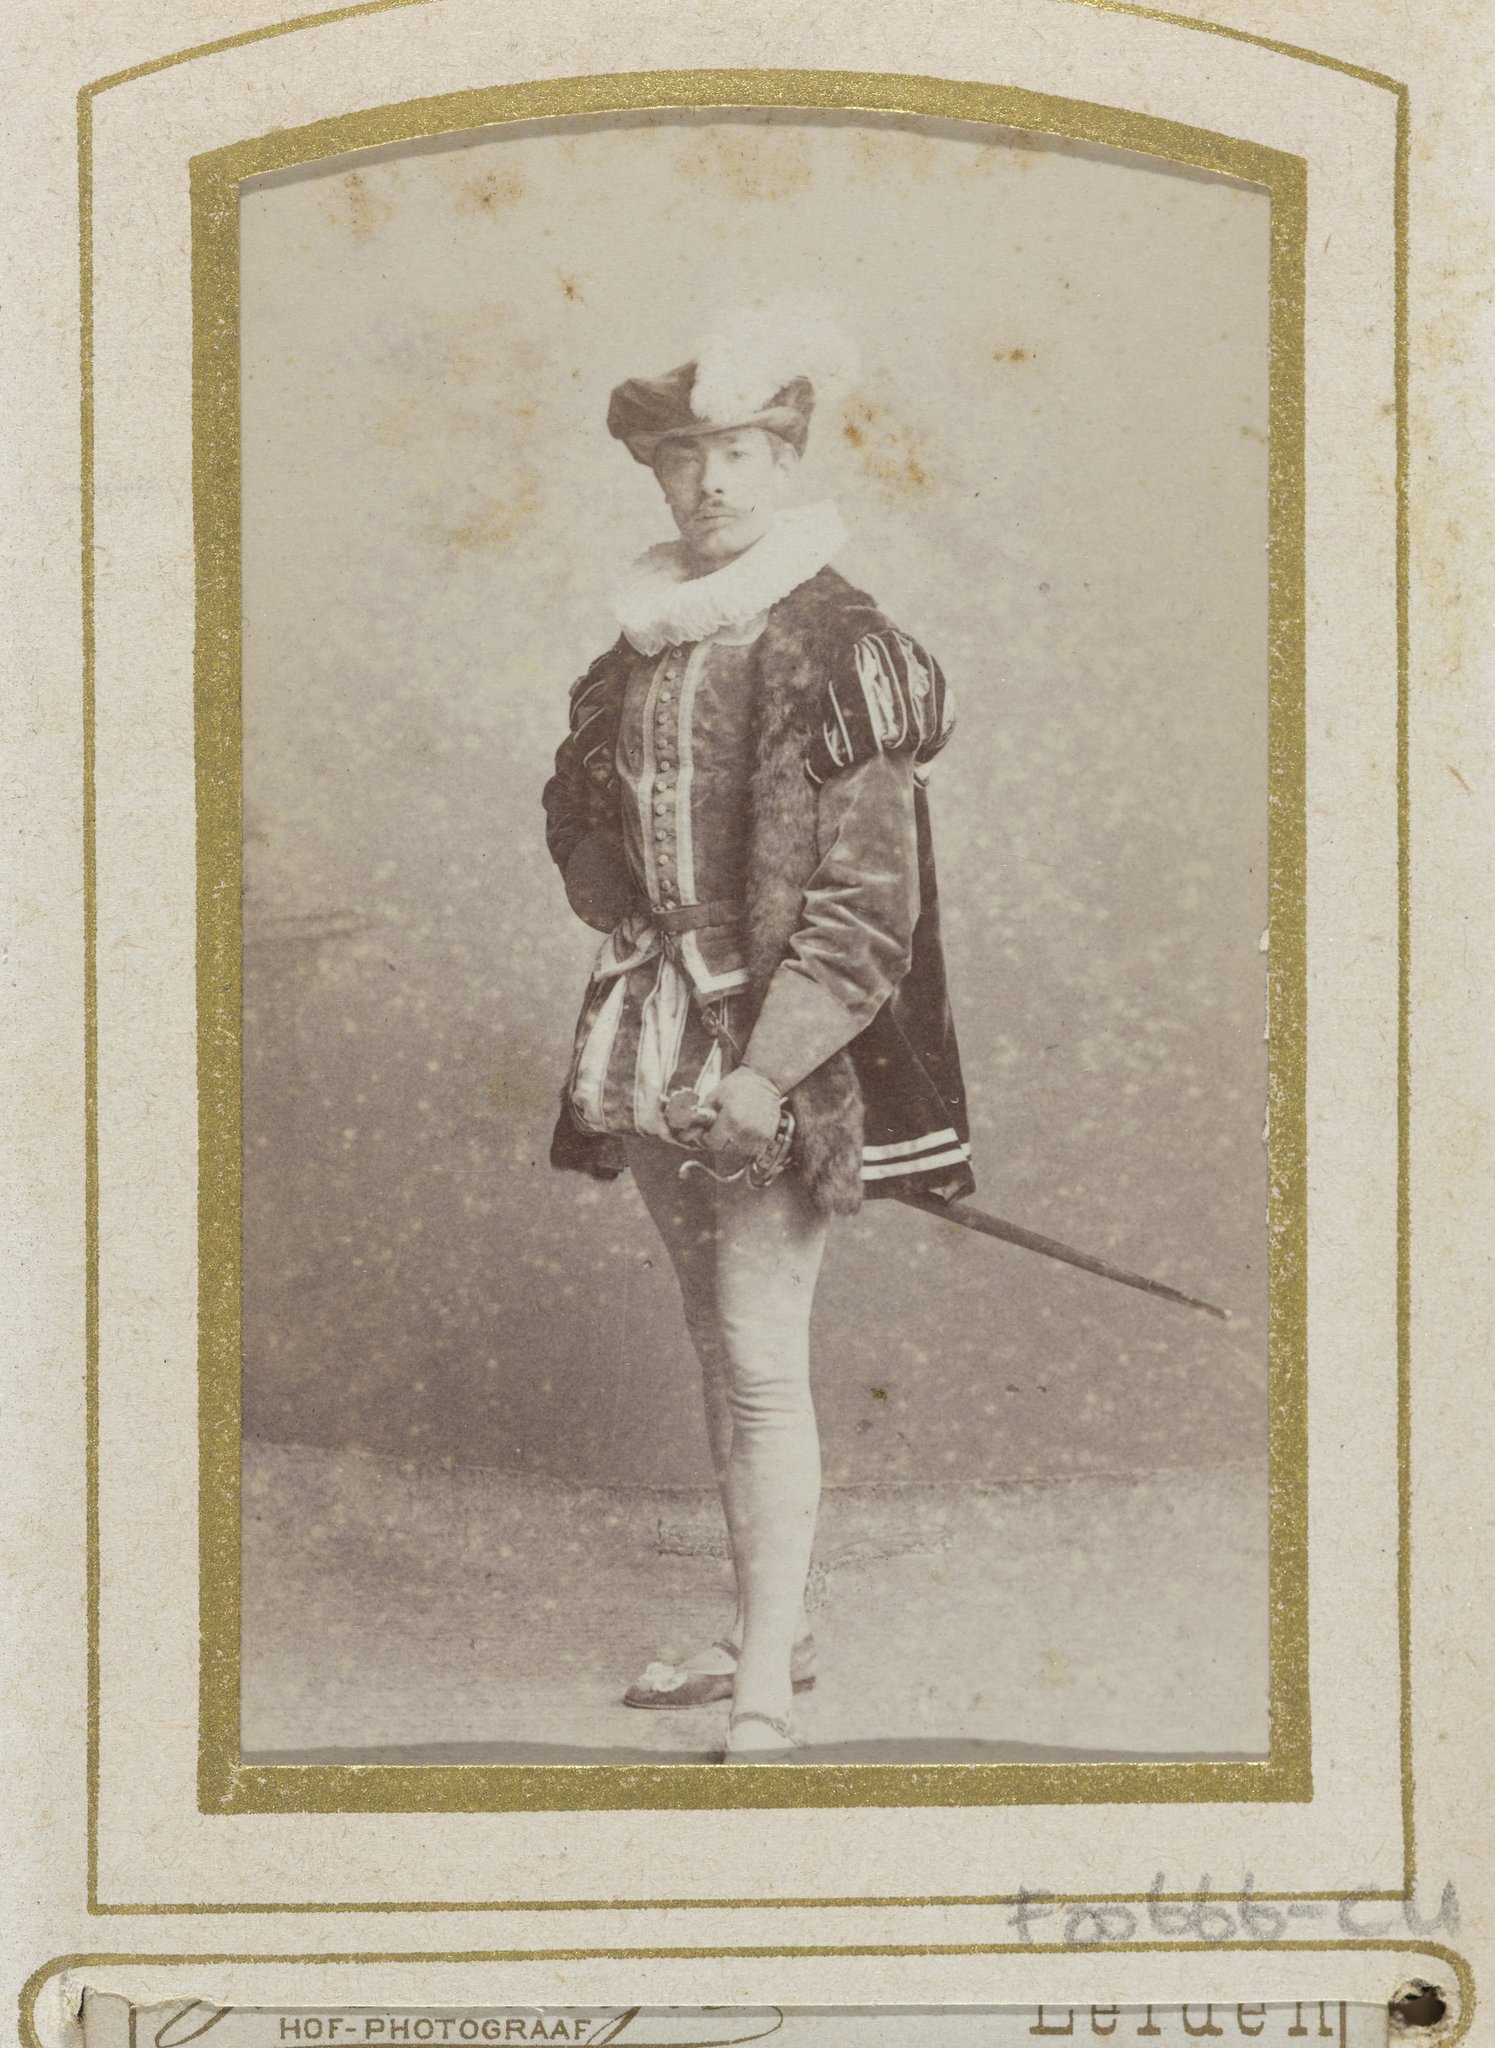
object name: carte de visite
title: Portret van een jonge man in kostuum met degen, aangeduid als N.A. de Joncheere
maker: jan goedeljee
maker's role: fotograaf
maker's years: 1824-1905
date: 1860-1905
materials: cardboard, photographic support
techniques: albumen print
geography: leiden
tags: historical persons, historical costume, hacking and thrusting weapons: rapier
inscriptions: name: ‘N. A. de Joncheere./ 207.’, inscription: ‘J. Goedeljee/ Photograaf/ Z. K. H. PRINS ALEXANDER/ der Nederlanden/ PRINS van ORANJE/ en H. K. H./ PRINSES HENDRIK/ der Nederlanden/ Hoogewoerd 160/ nabij de Plantage.’